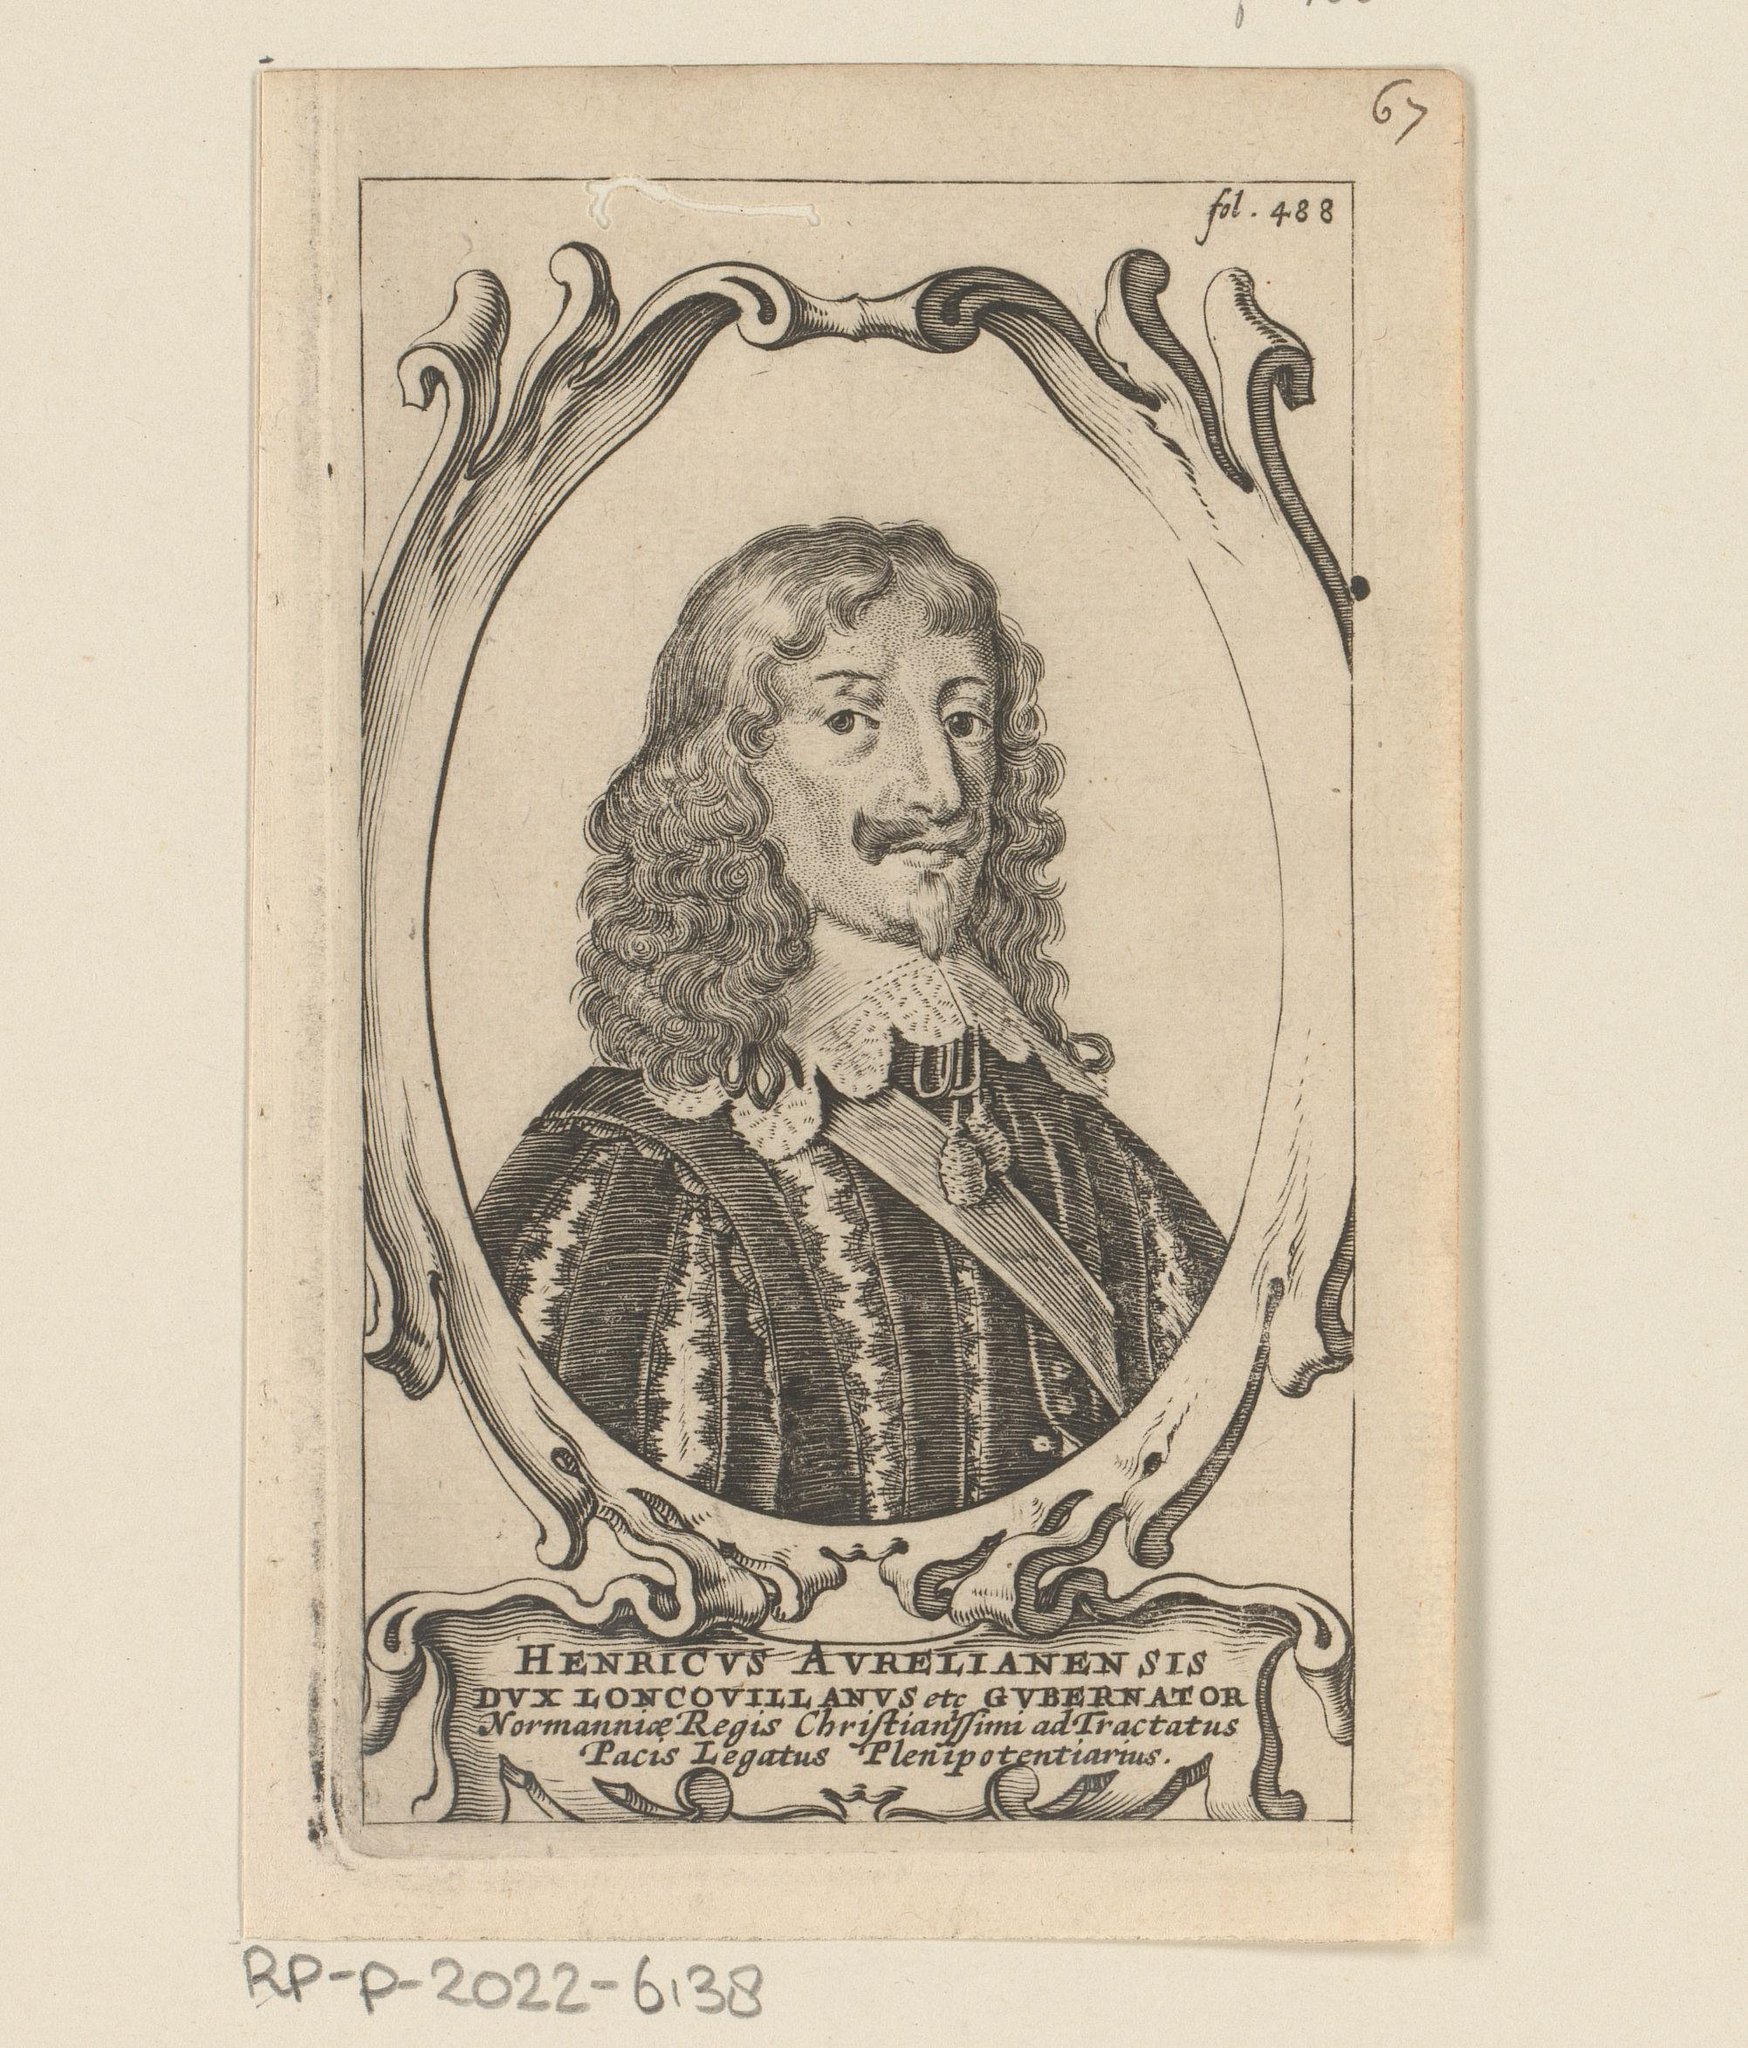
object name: book illustration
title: Portret van Hendrik II van Longueville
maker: Anonymous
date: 1656-1666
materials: paper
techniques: engraving, etching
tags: historical persons, ruler, sovereign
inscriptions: number: ‘67’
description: Prent waarschijnlijk uit: Brachelius, Johannes Adolphus. Historia nostri temporis, dat is geschiedenis onses tijdts (…). Rotterdam: Andries van Hoogenhuysen, 1656. Prent ook gebruikt in de 1666-editie.